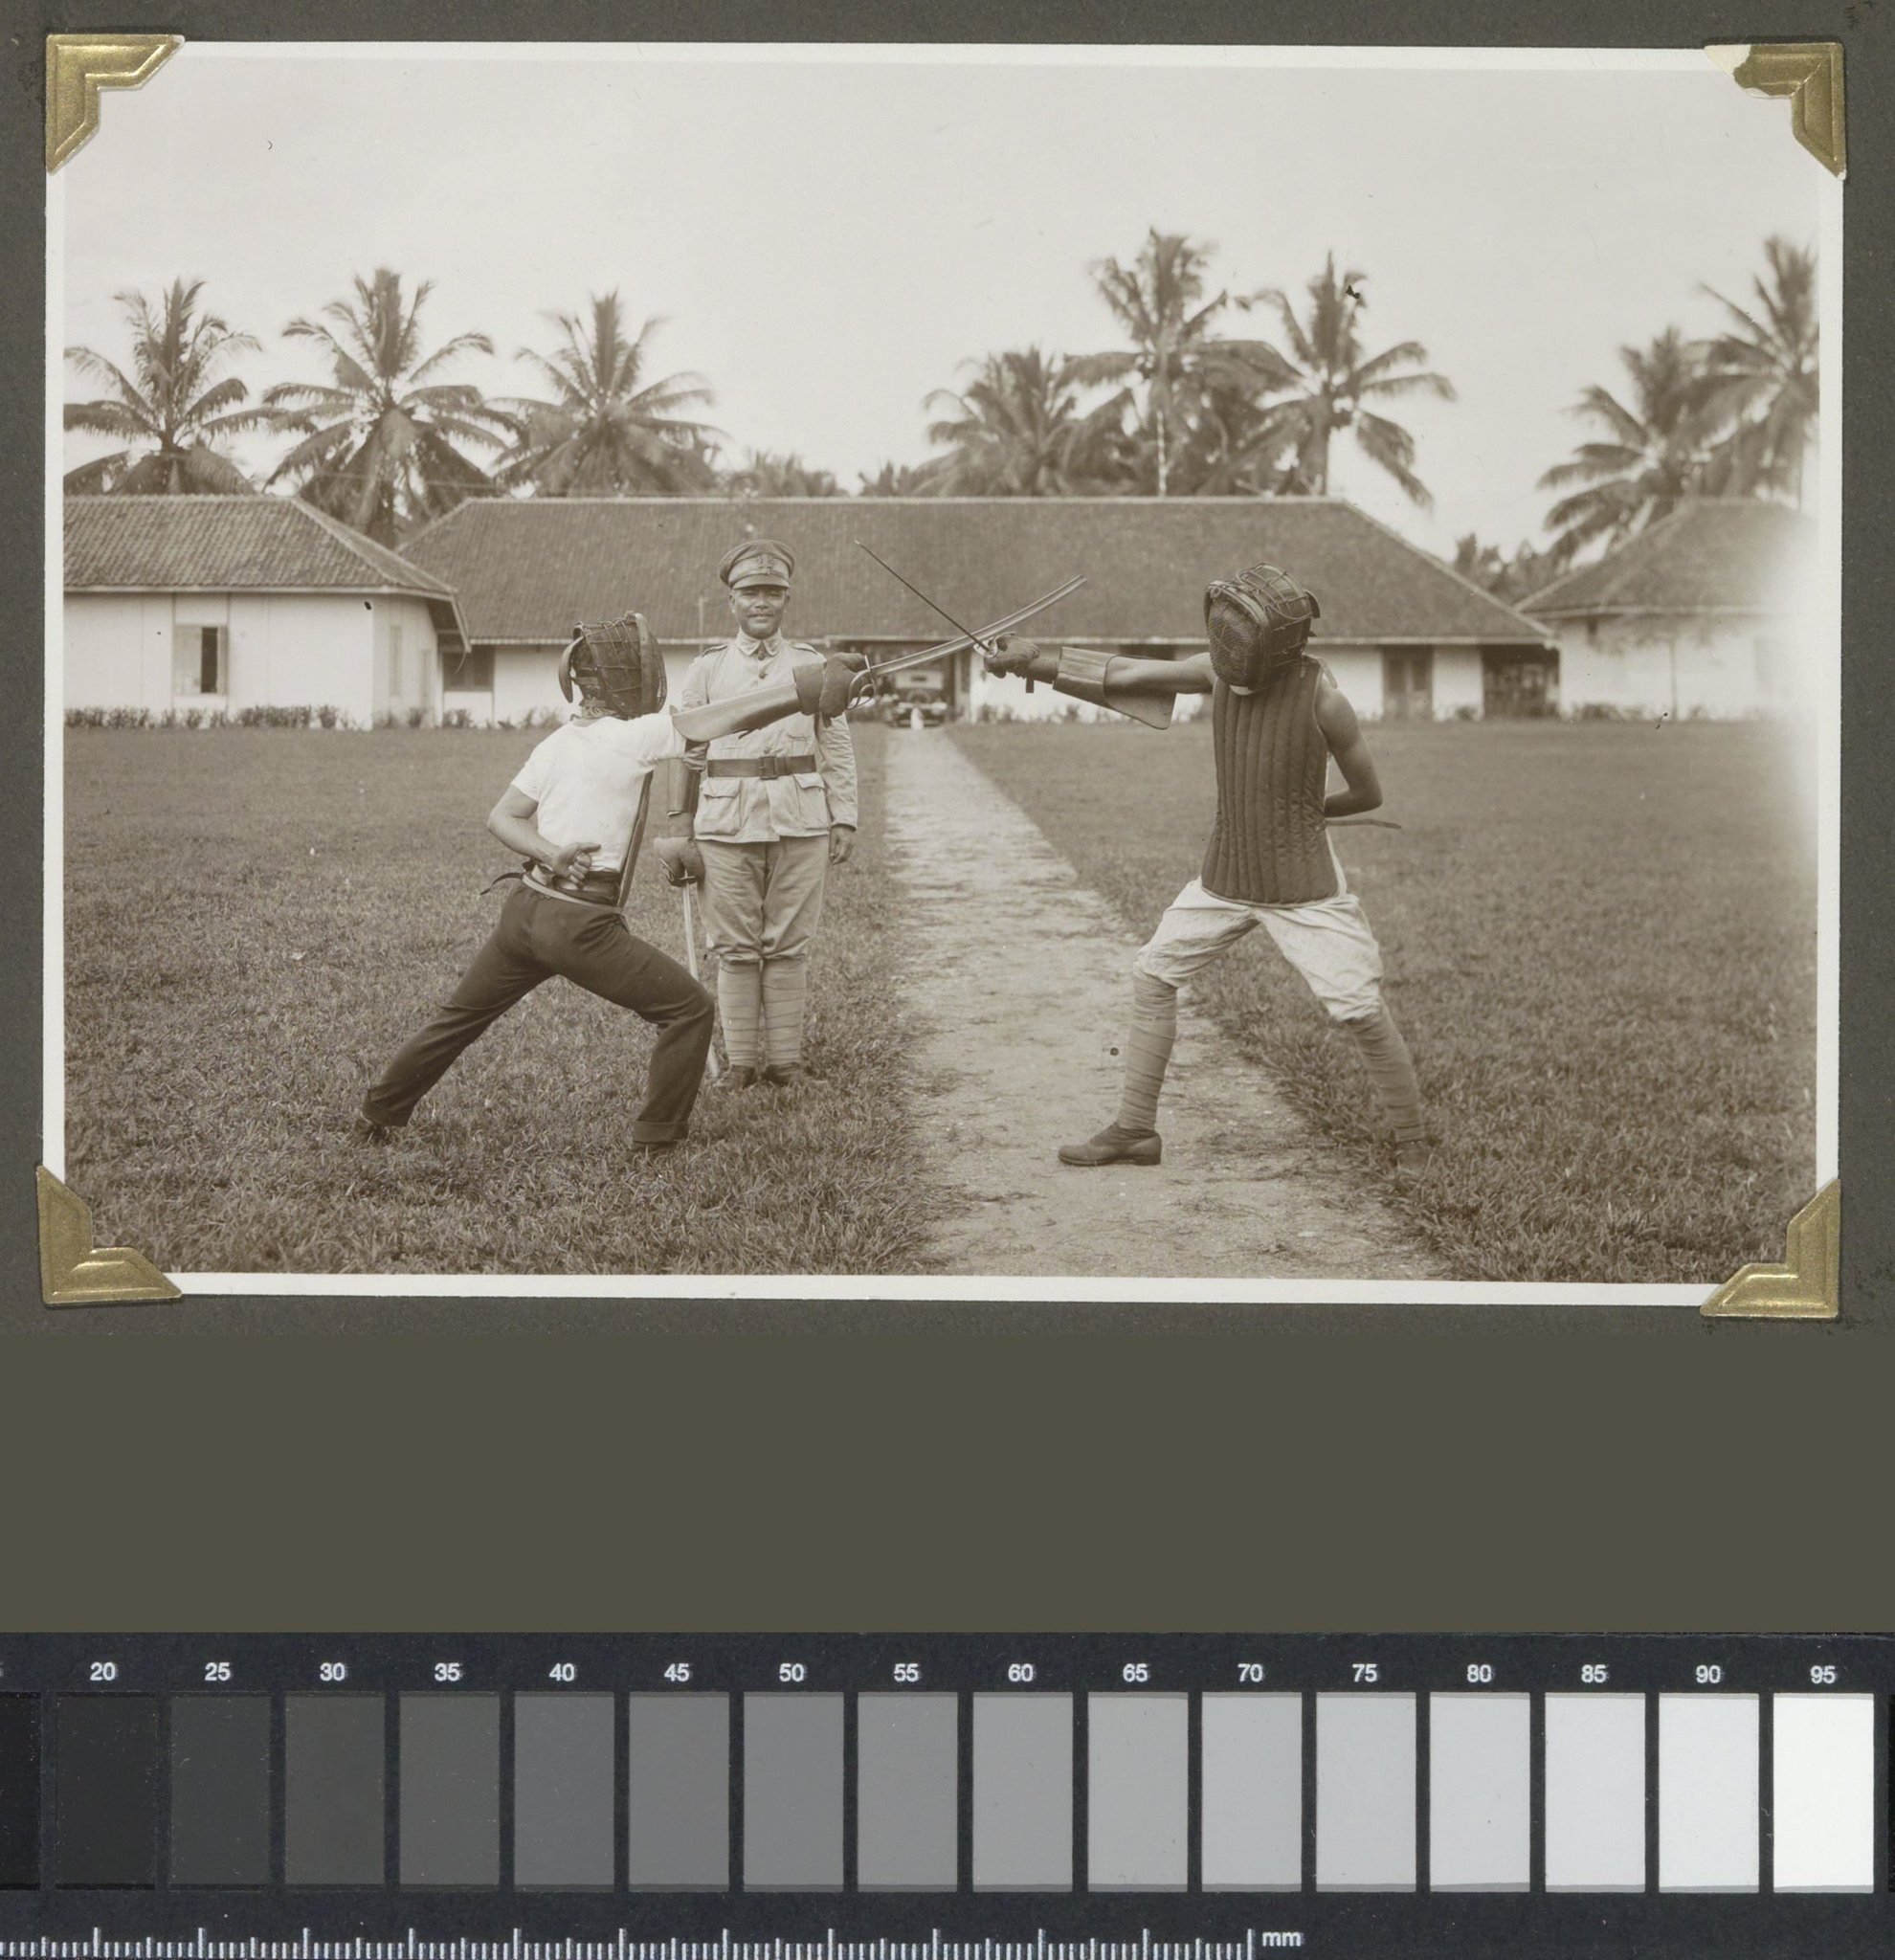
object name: photograph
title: Leden van de politie in Lampong tijdens schermlessen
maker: Anonymous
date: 1932-1933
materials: photographic support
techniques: gelatin silver print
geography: lampung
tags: fencing (sport), police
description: Onderdeel van Herinneringsalbum voor F.J. Junius, vertrekkend resident van Lampong (Zuid-Sumatra).